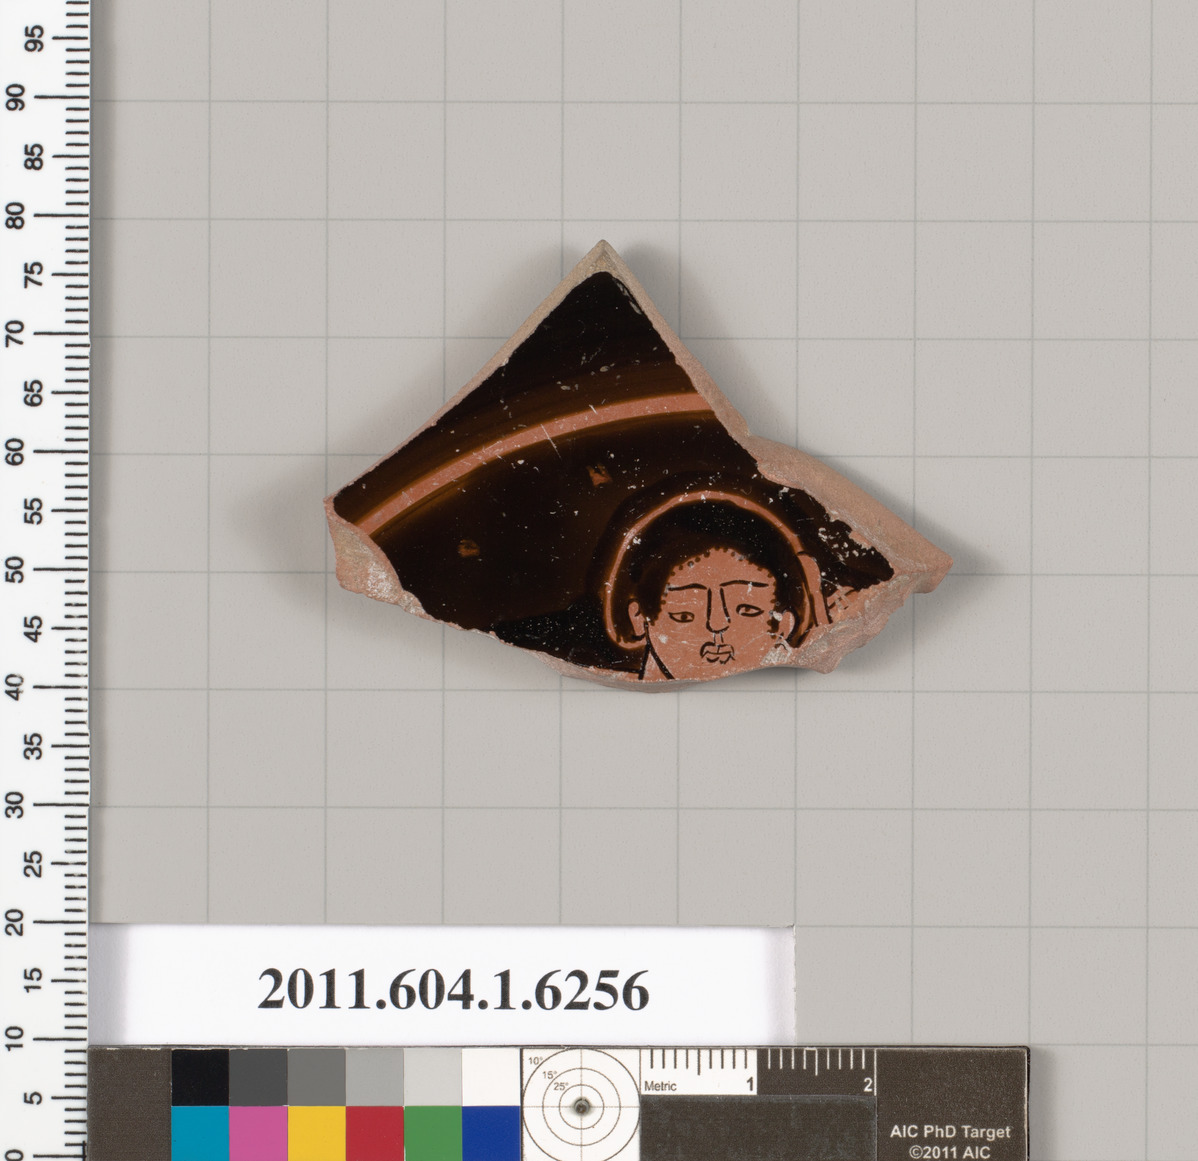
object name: kylix fragment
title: Terracotta fragment of a kylix (drinking cup)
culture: greek, attic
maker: onesimos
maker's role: artist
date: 500-480 BCE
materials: terracotta